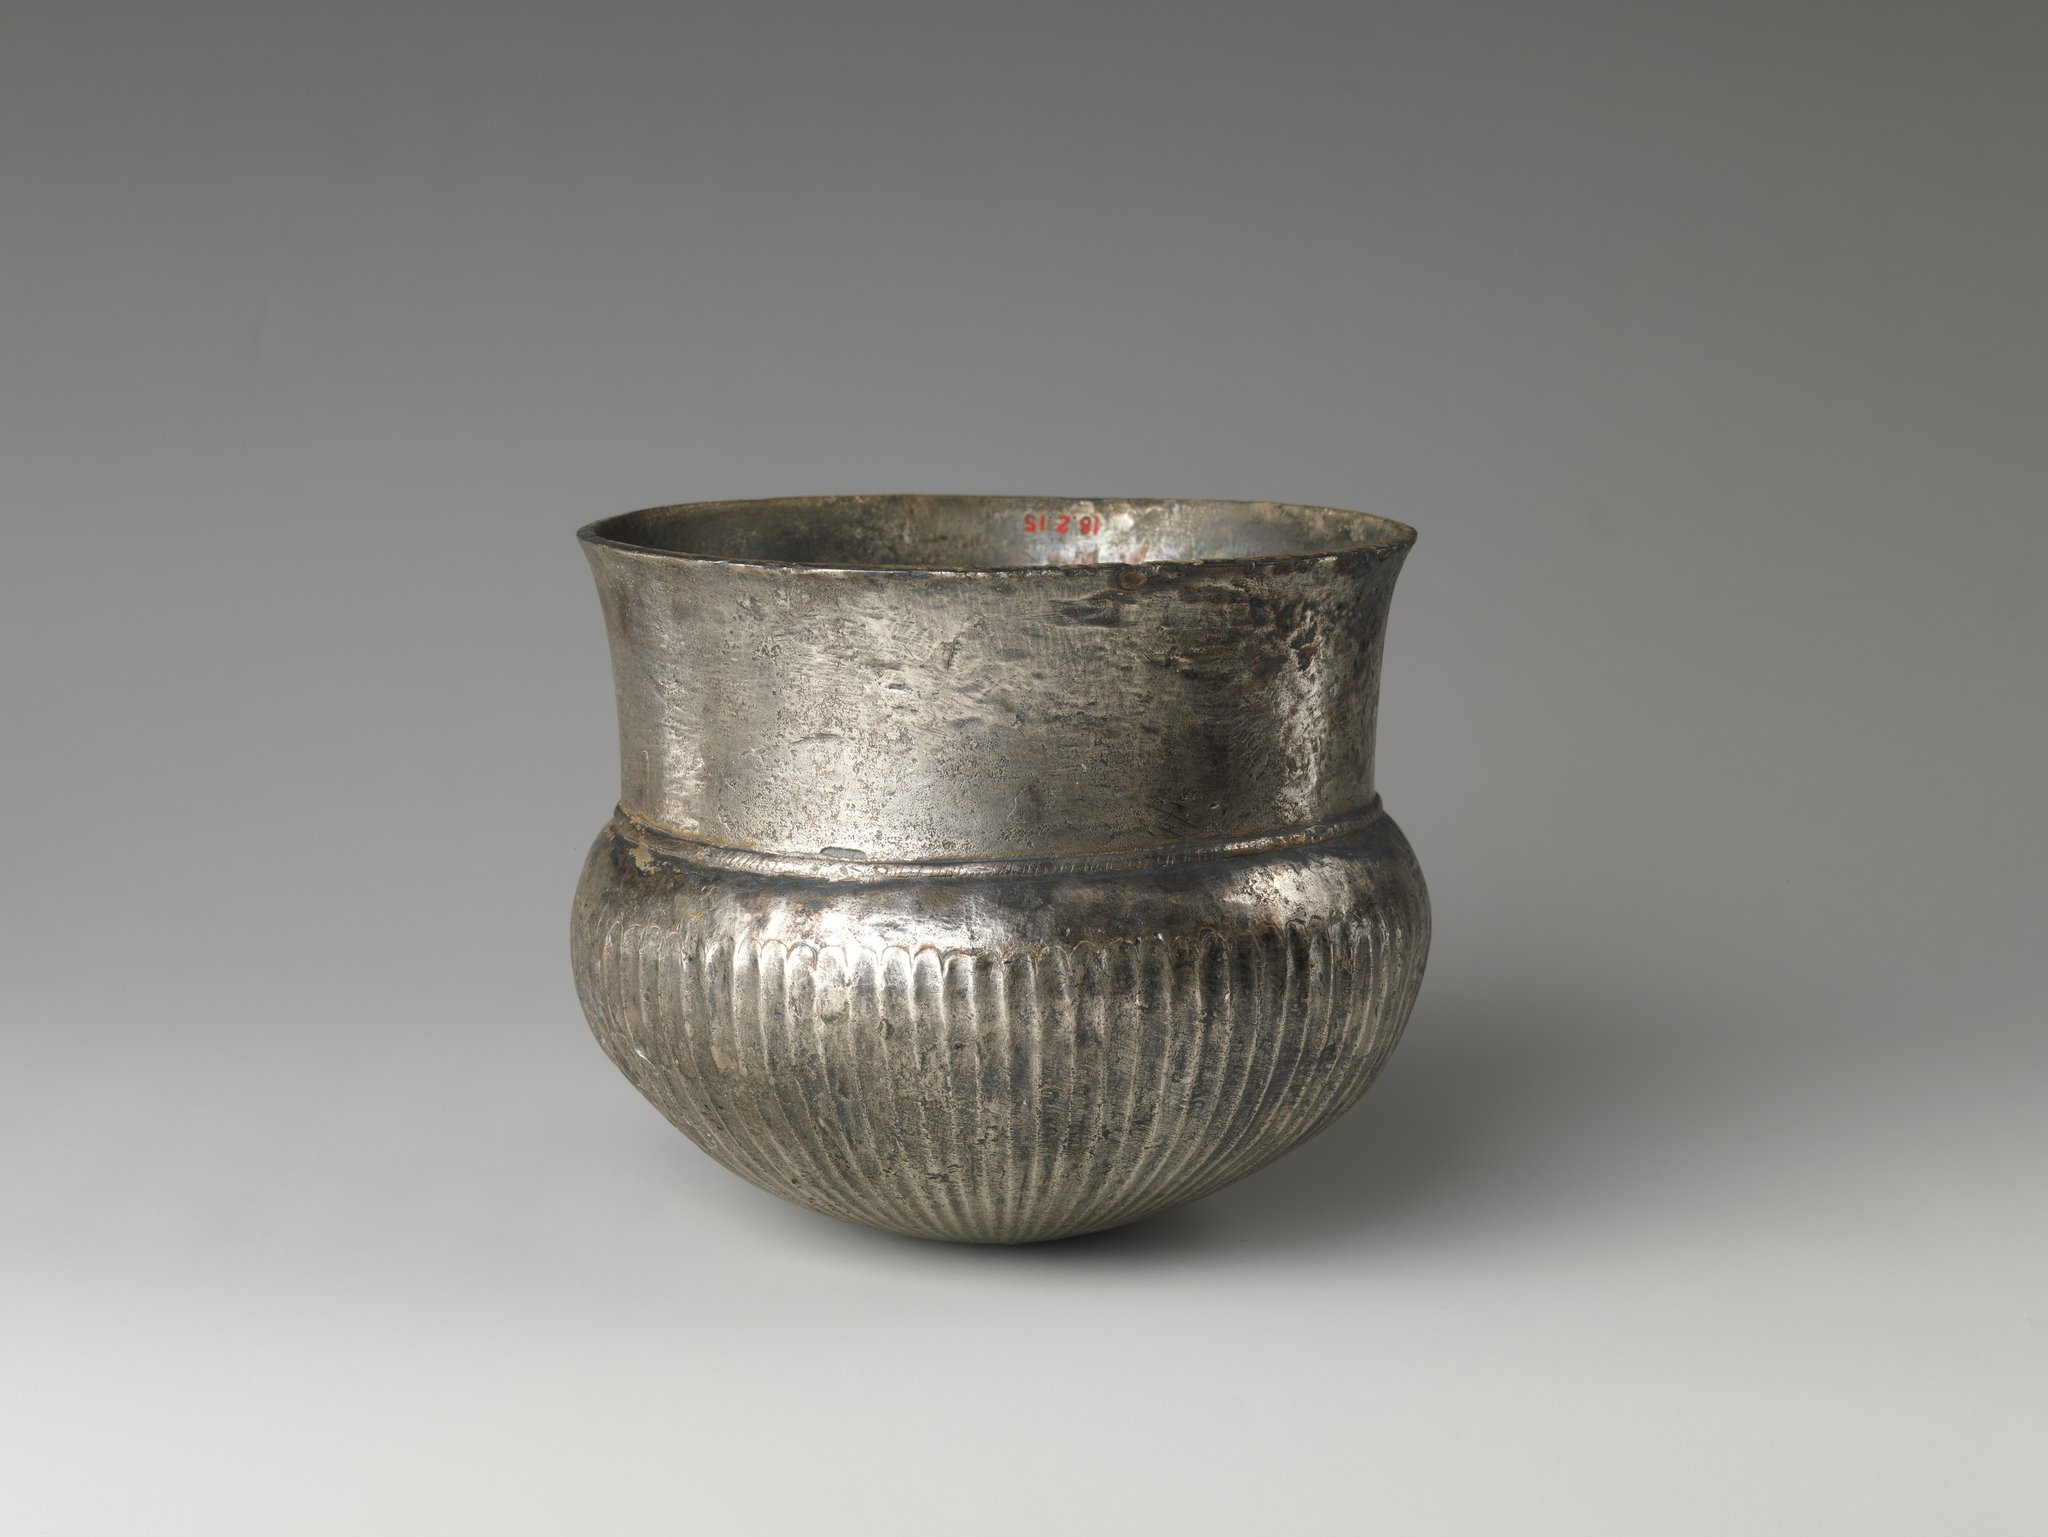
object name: bowl, fluted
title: Bowl with flutes f rom shoulder to rosette at base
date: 400-301 BCE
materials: silver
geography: egypt